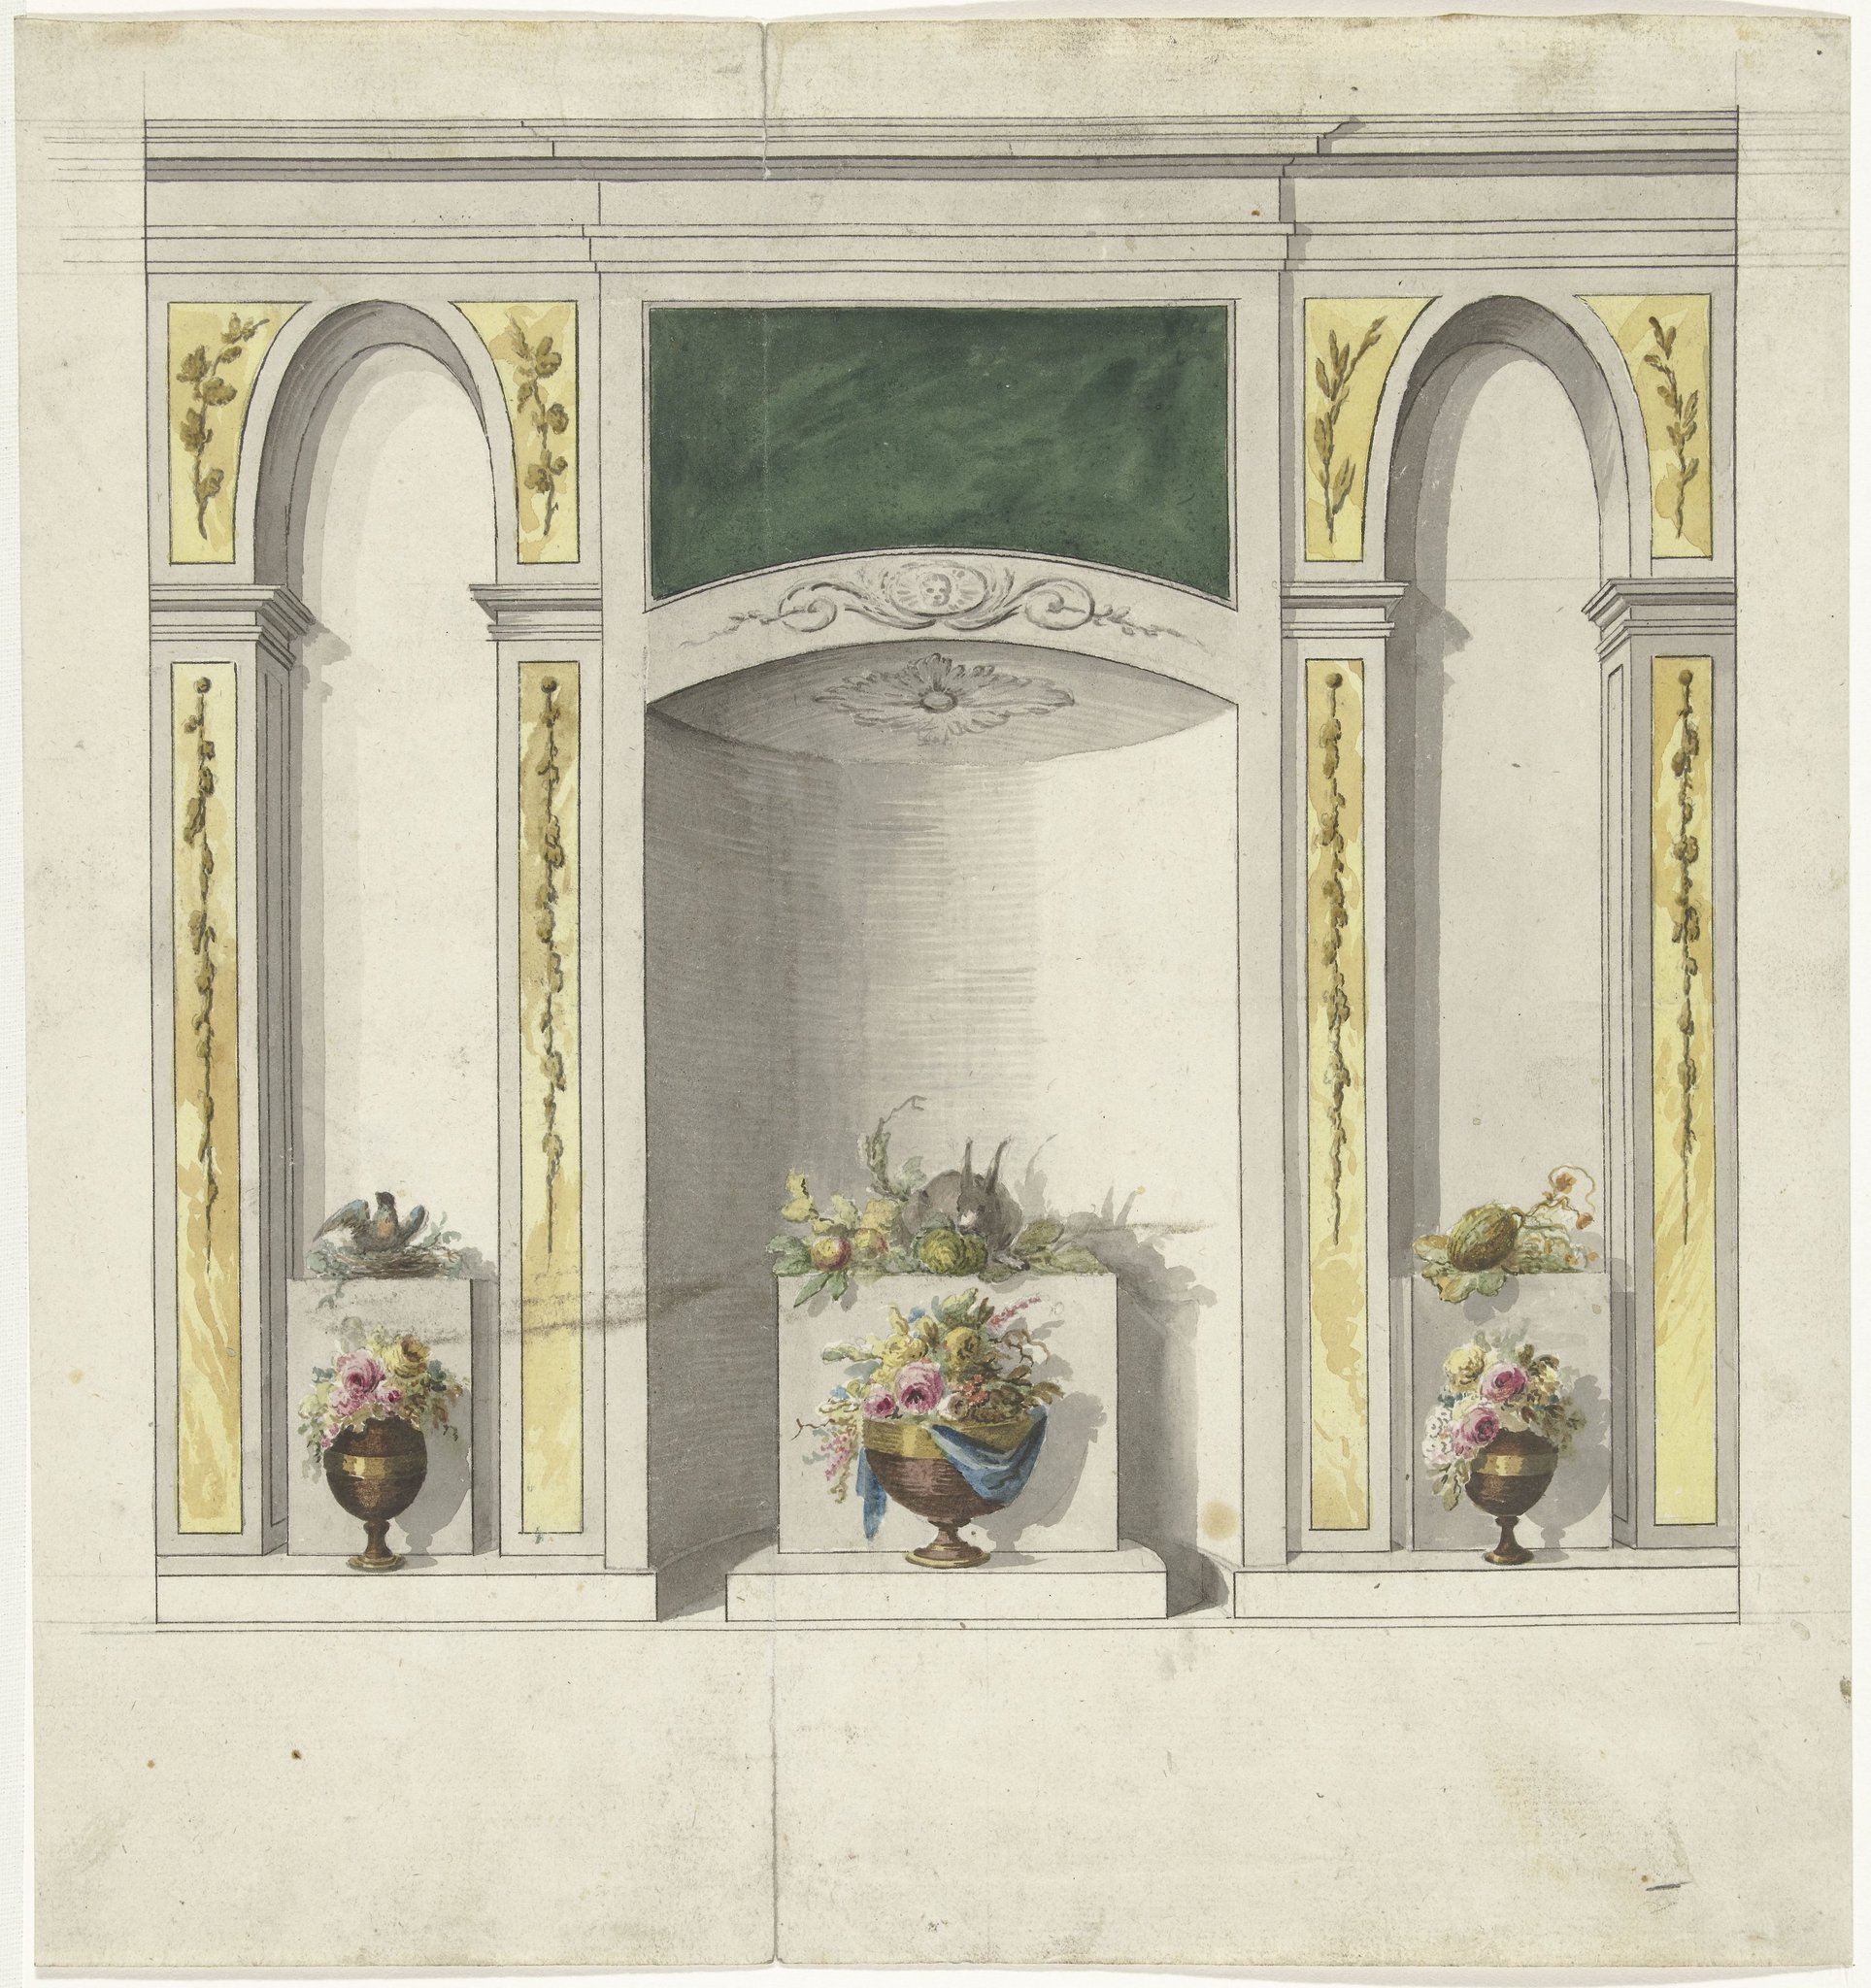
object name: design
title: Ontwerp voor kamerversiering met drie nissen waarin bloemenvazen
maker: abraham meertens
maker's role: draughtsman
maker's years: 1757-1823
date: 1767-1823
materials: ink, paper, pencil, watercolor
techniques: brush, pen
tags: wall-covering